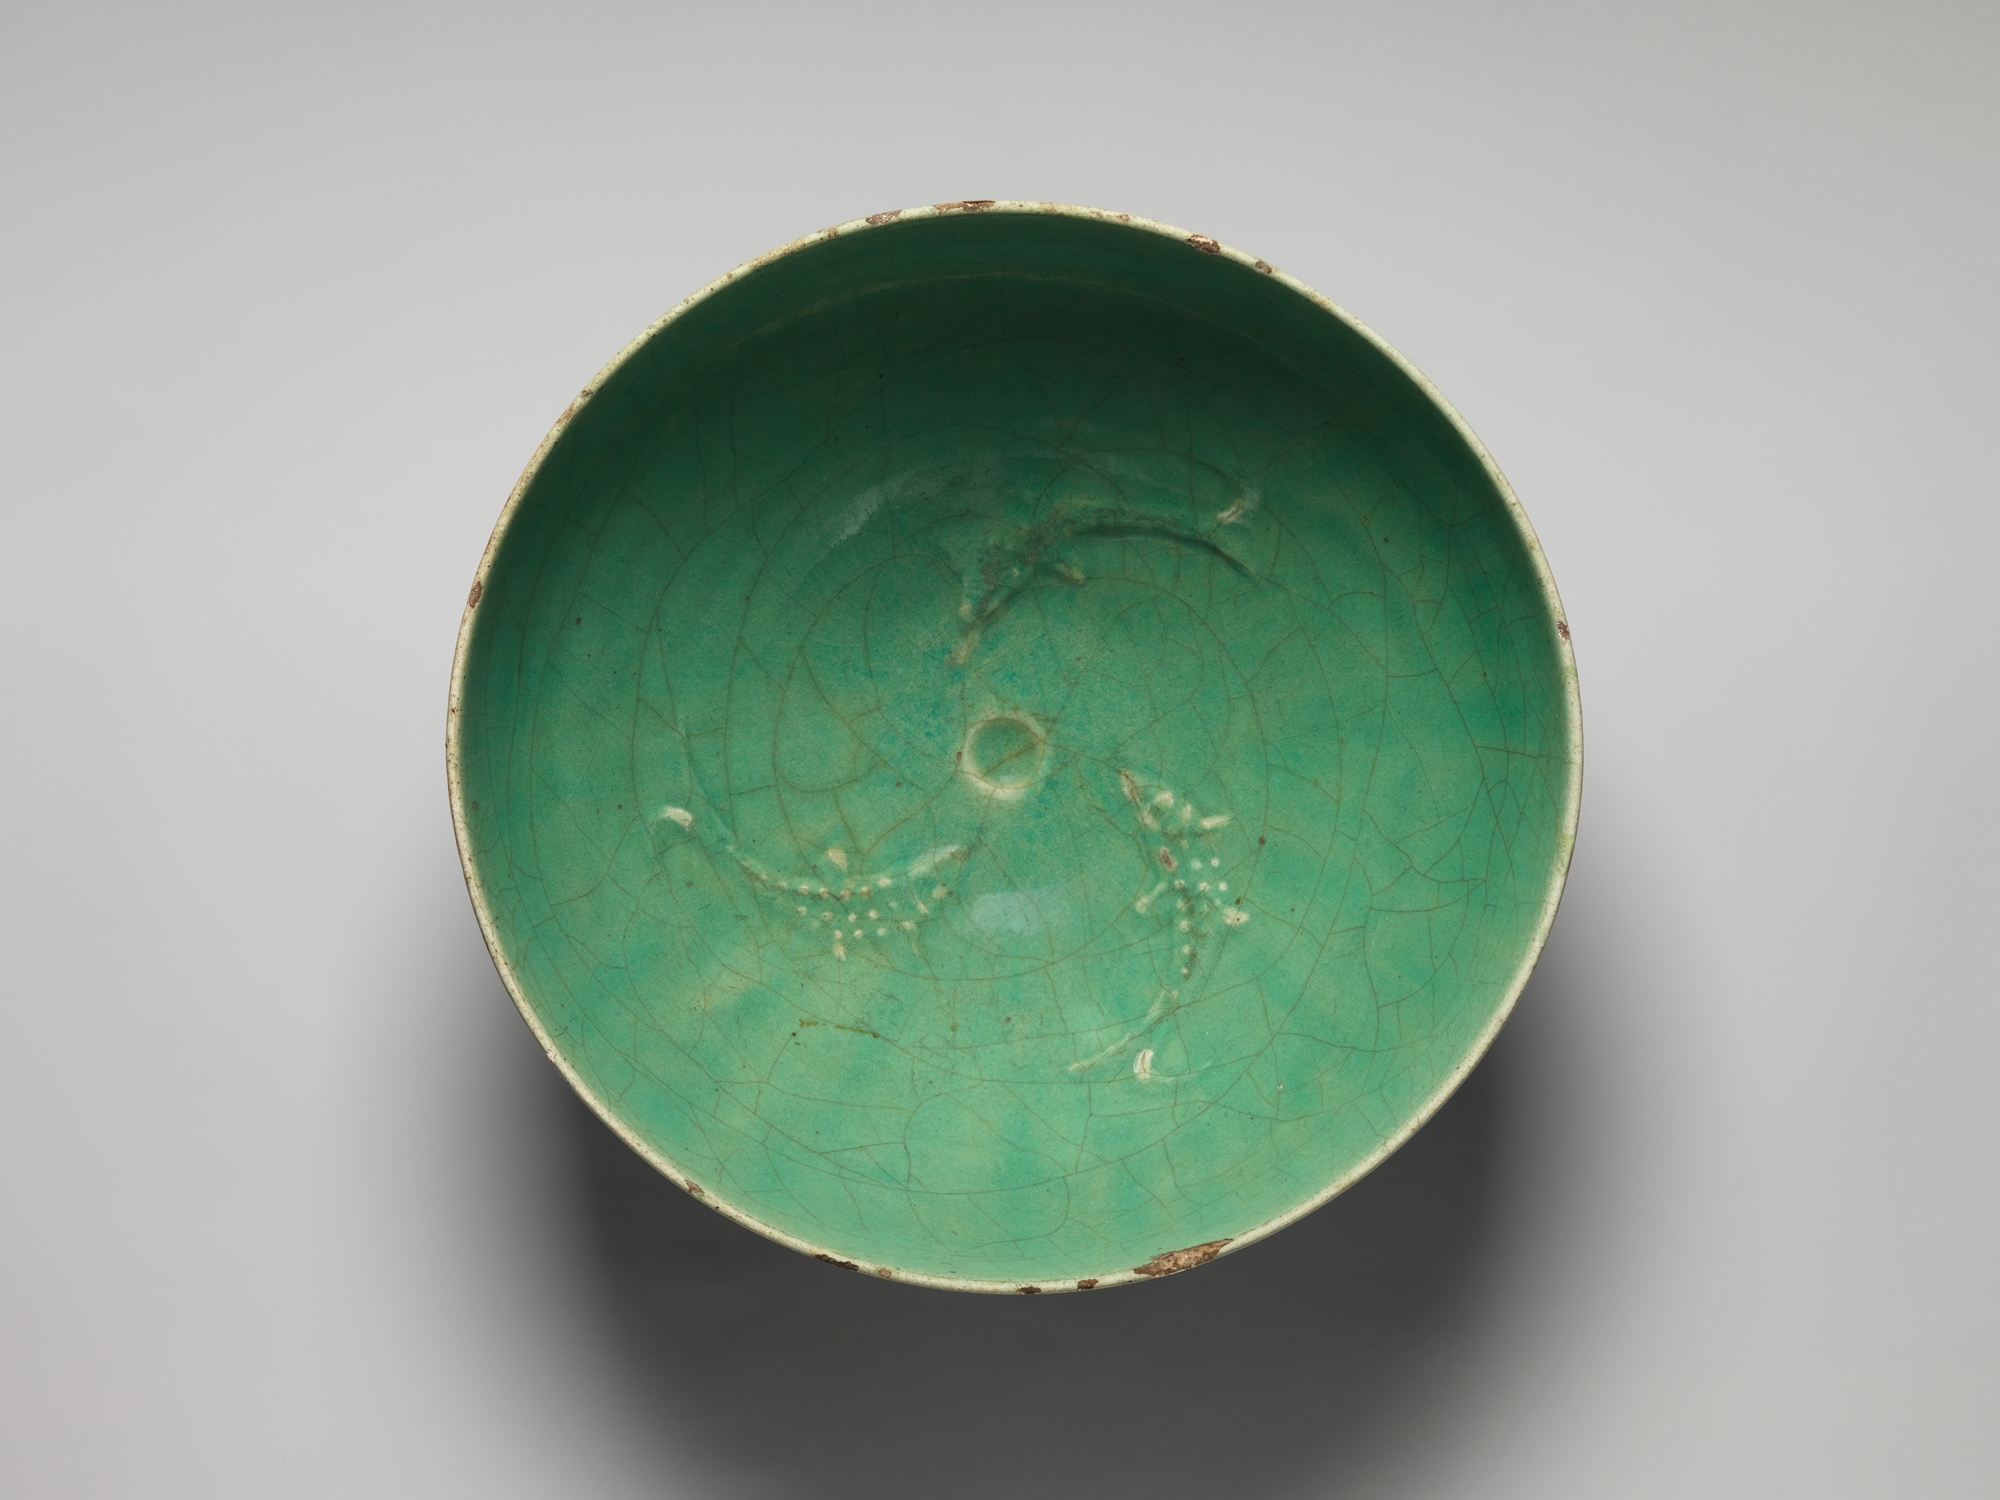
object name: bowl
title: Bowl with Fish Motifs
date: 1301-1350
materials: stonepaste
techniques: glazing, molding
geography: iran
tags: fish